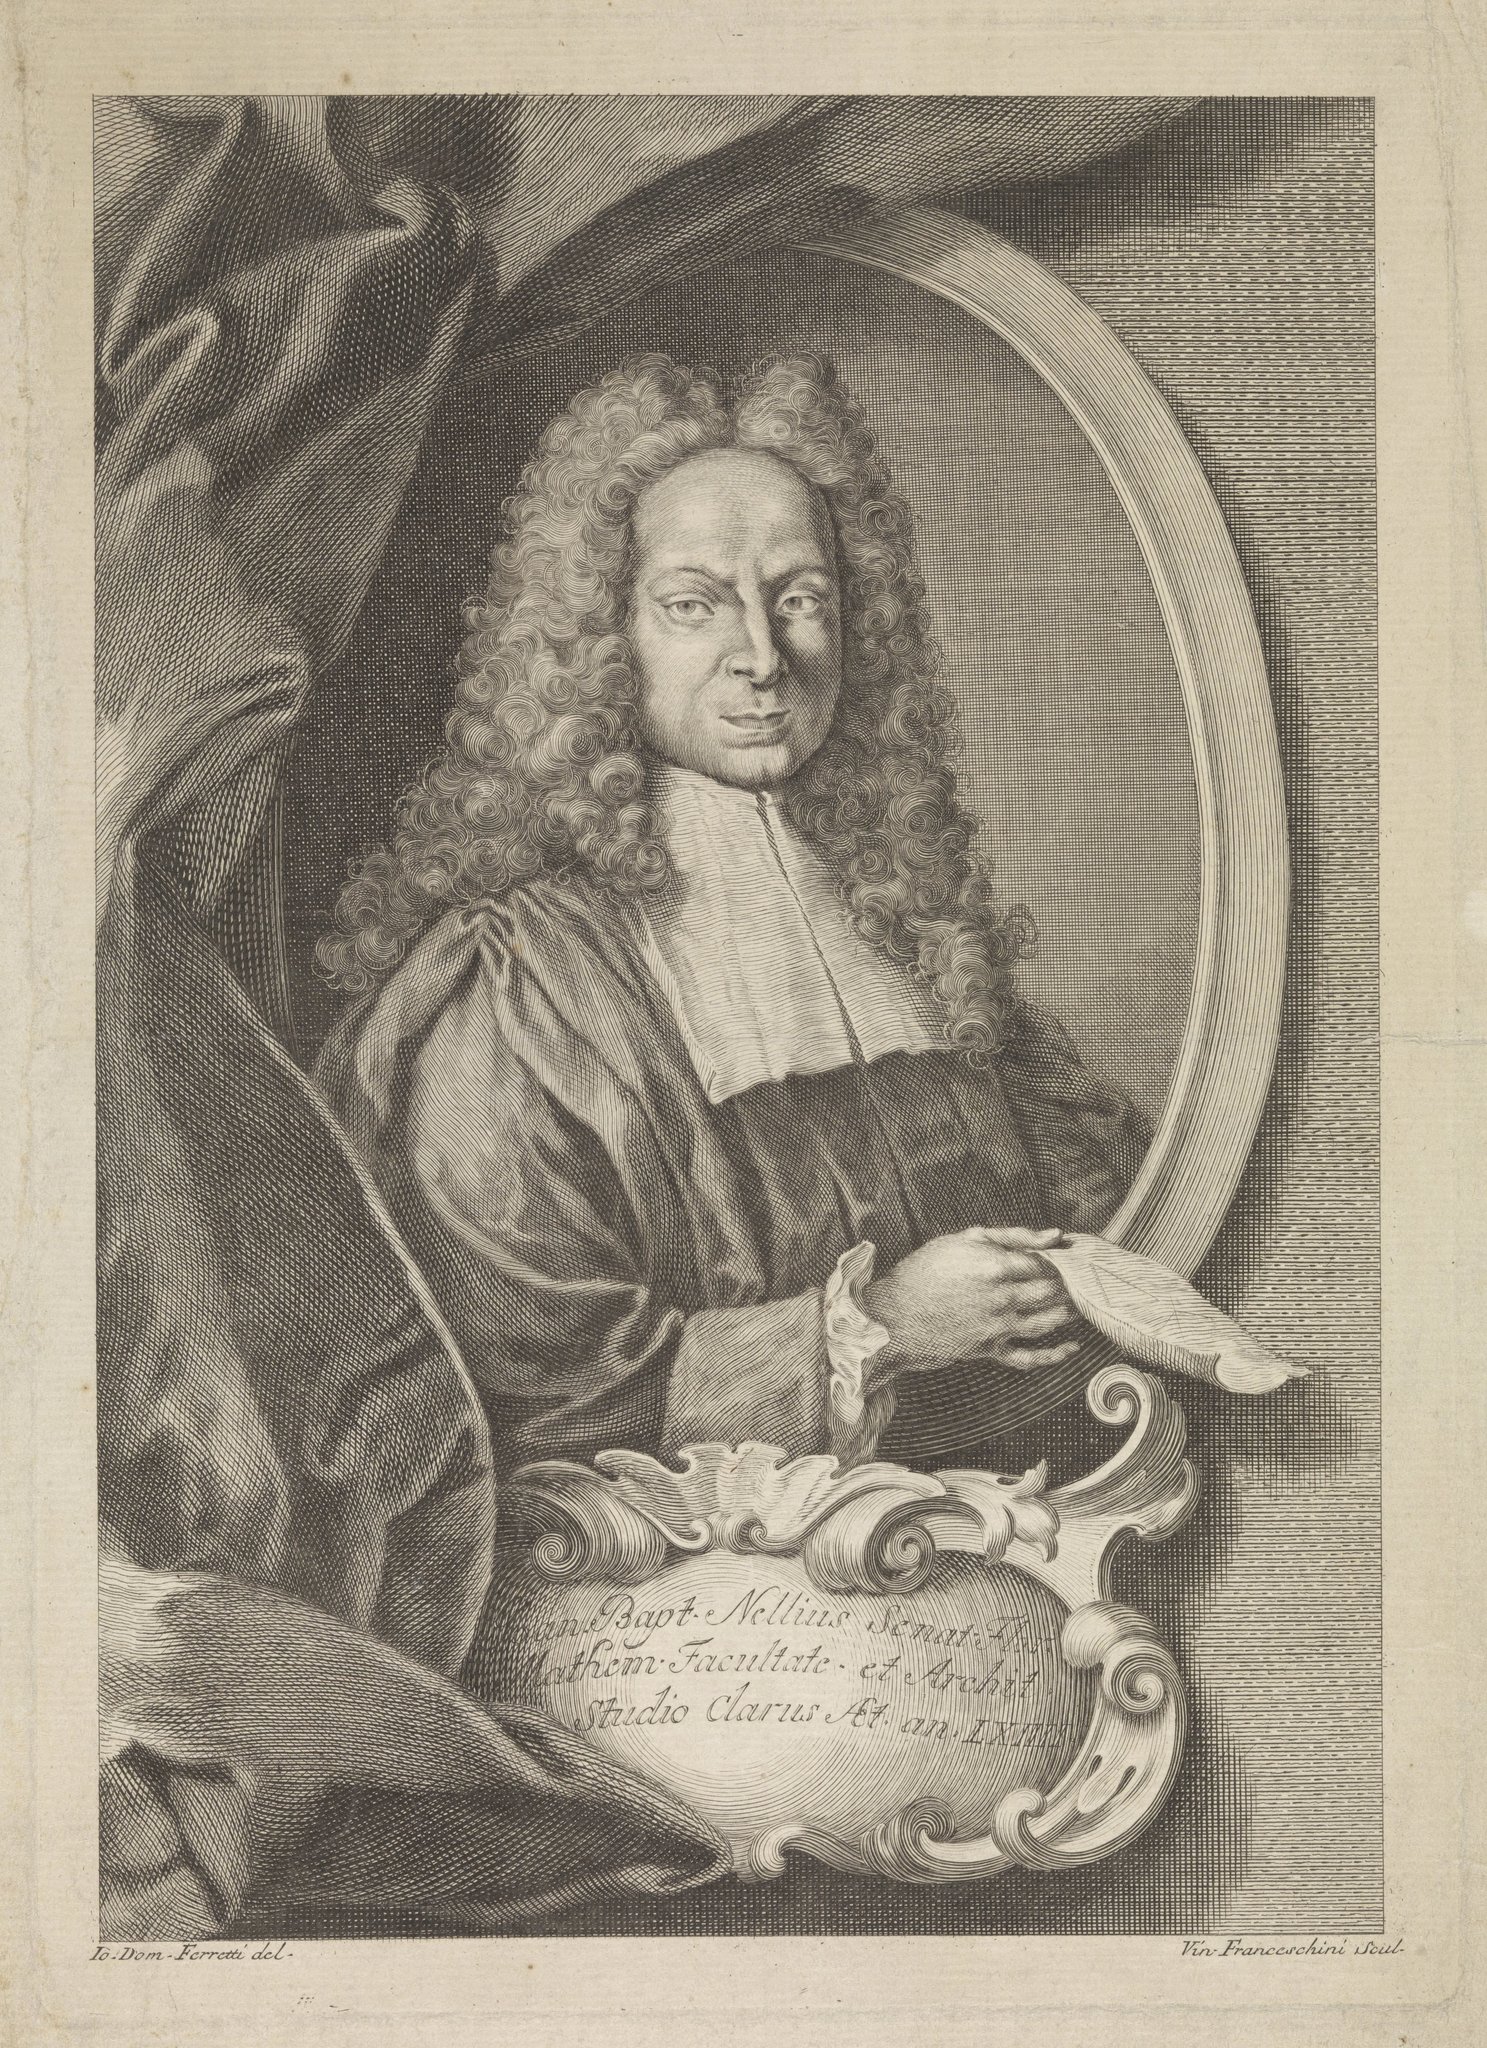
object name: print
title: Portret van architect Giovanni Battista Nelli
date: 1690-1750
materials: paper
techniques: engraving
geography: italy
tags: historical persons, portrait, self-portrait of architect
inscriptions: collector's mark: Lugt 2228